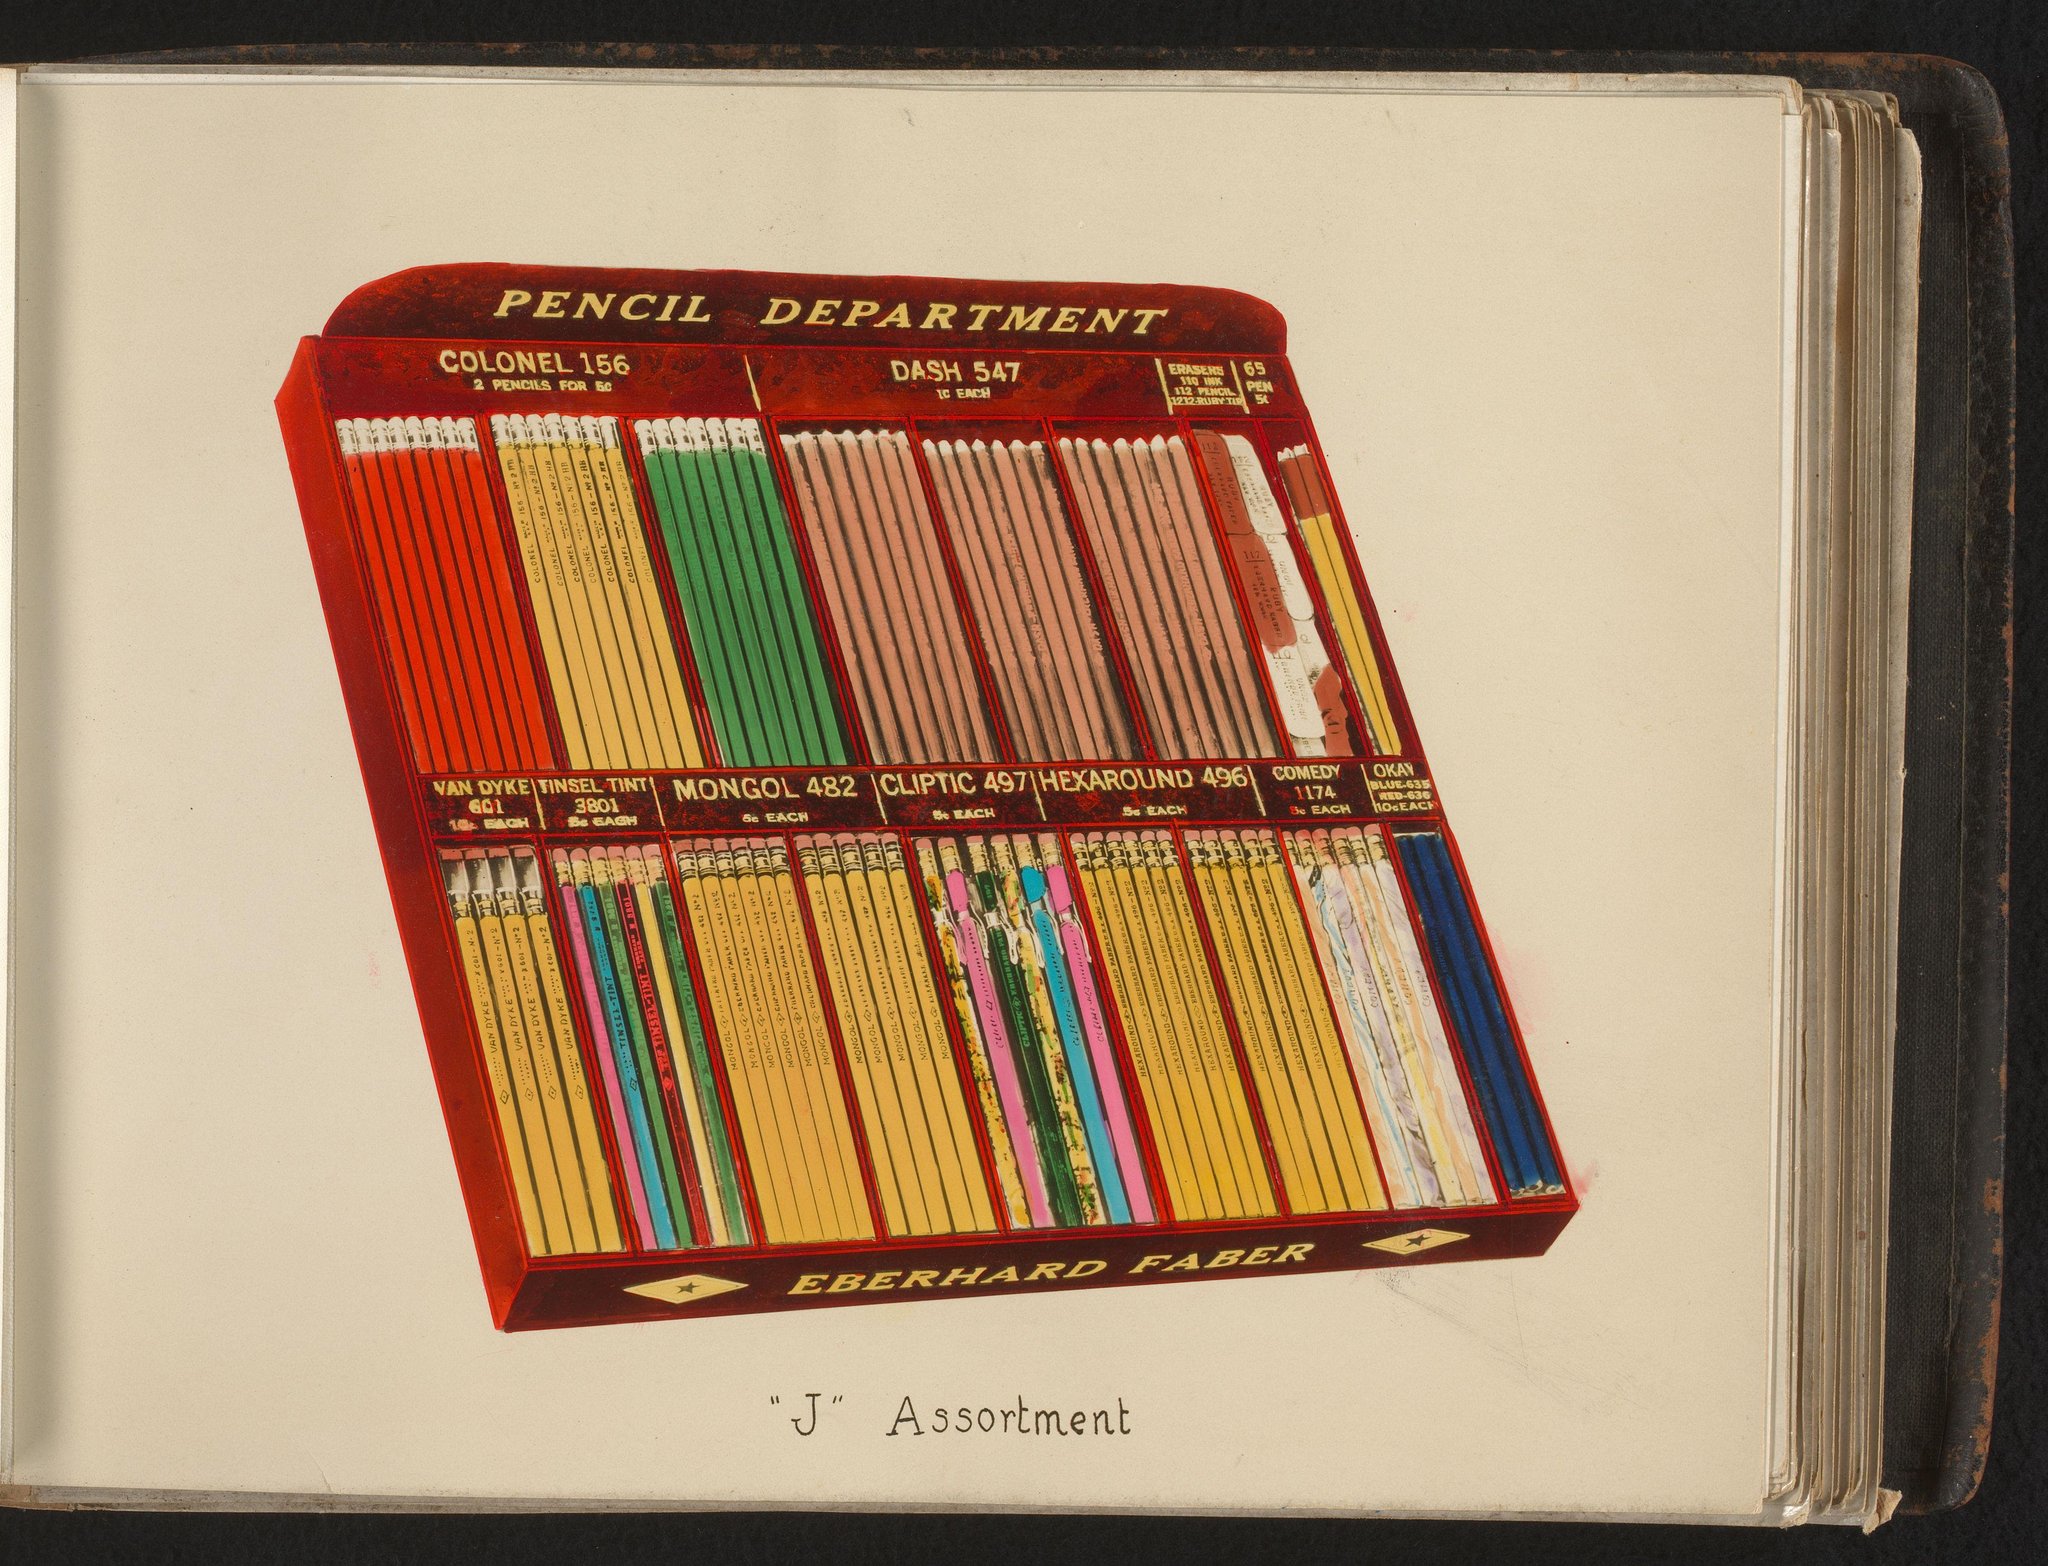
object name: album leaf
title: Standaard met potloden van Eberhard Faber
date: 1915-1935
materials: paper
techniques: gelatin silver print, hand coloring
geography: springfield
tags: pencil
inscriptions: stamp: ‘Paramount/ Commercial Studios/ 145 Chestnut St./ Springfield - Mass.’